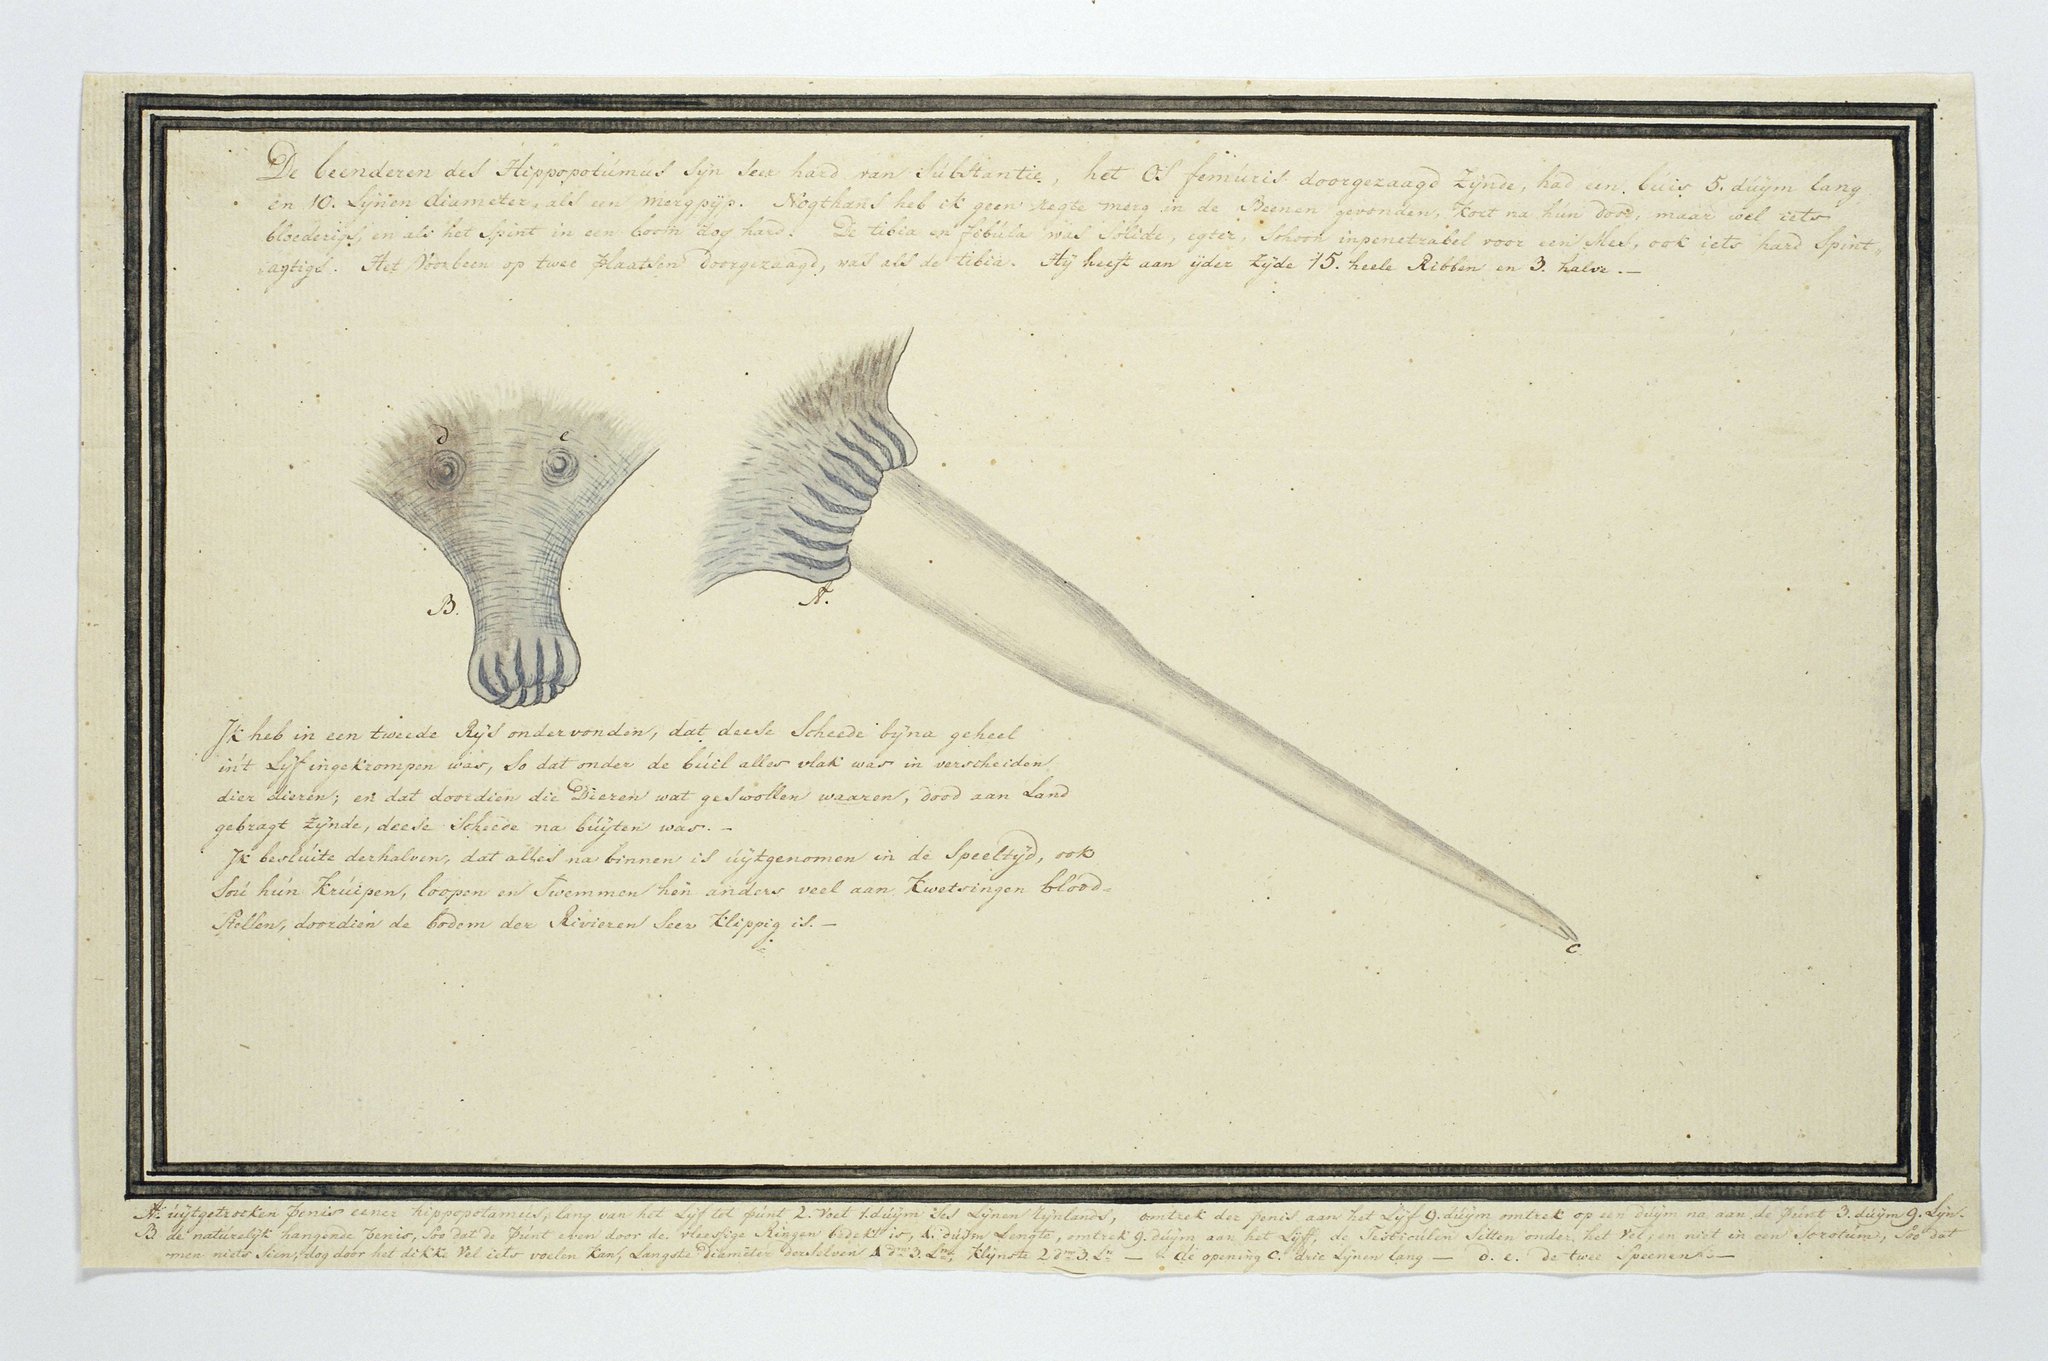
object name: drawing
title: Hippopotamus amphibius capensis (Hippopotamus)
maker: robert jacob gordon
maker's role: draughtsman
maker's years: 1743-1795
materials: chalk, ink, paper, pencil, watercolor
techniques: brush, pen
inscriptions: annotation: ‘zie : Rookmaker’